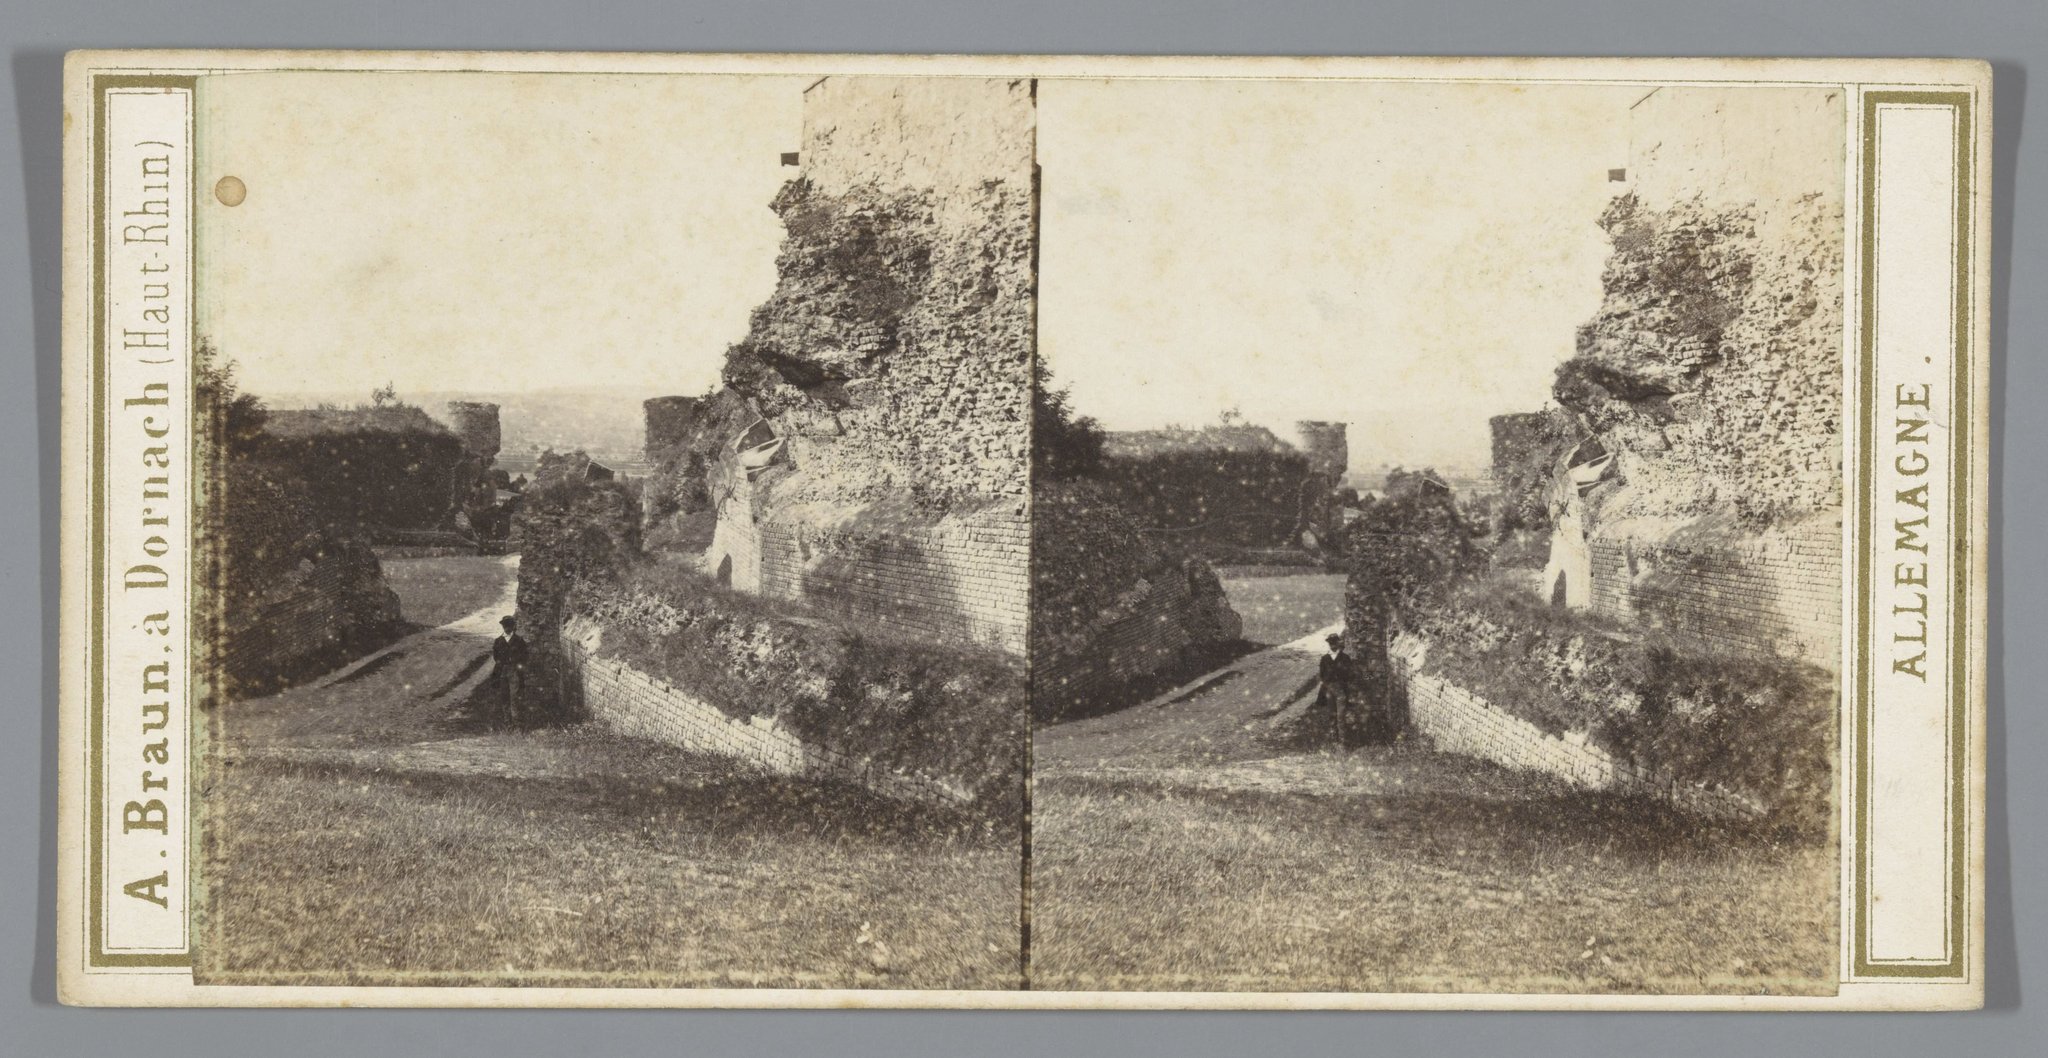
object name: stereograph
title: Allemagne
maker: Anonymous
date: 1860-1866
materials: cardboard, paper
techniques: albumen print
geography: trier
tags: amphitheatre, landscape with ruins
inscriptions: number: ‘No 2706.’